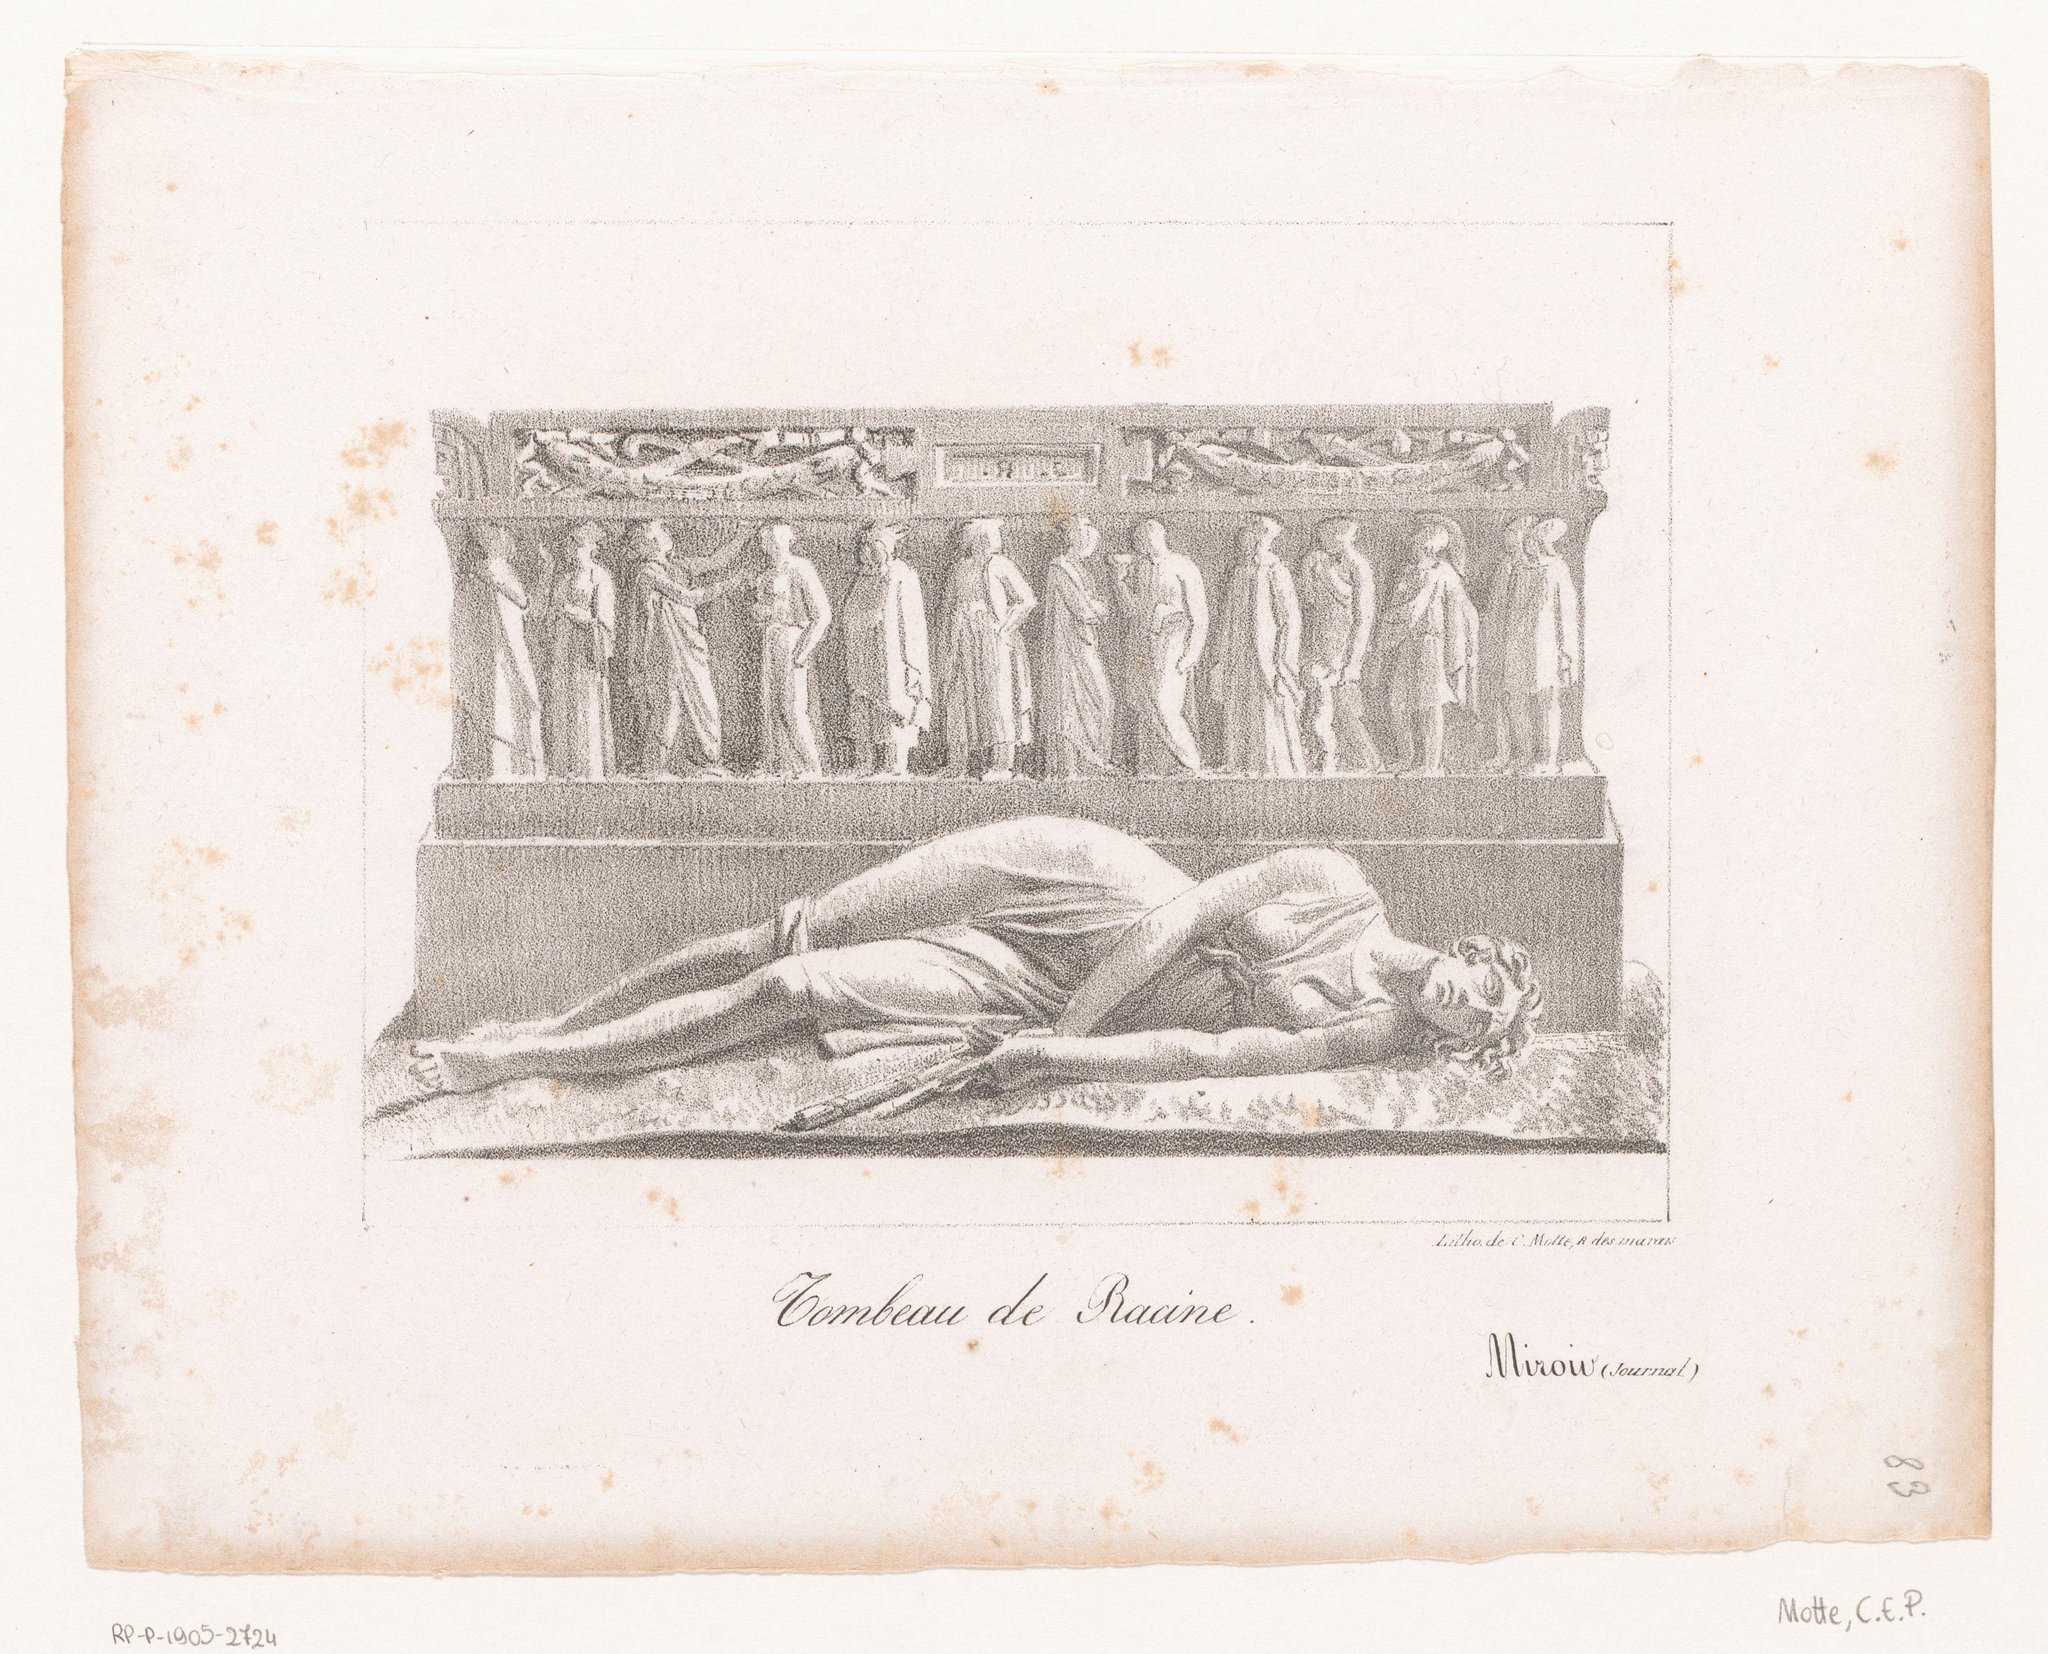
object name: print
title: Tombeau de Racine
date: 1821-1823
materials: paper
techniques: lithograph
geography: paris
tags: france, paris, jean racine, grave, tomb, writer, poet, author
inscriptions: collector's mark: Lugt 2228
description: Prent gebruikt in: Le Miroir des spectacles, des lettres, des mœurs et des arts, 1821-1823.